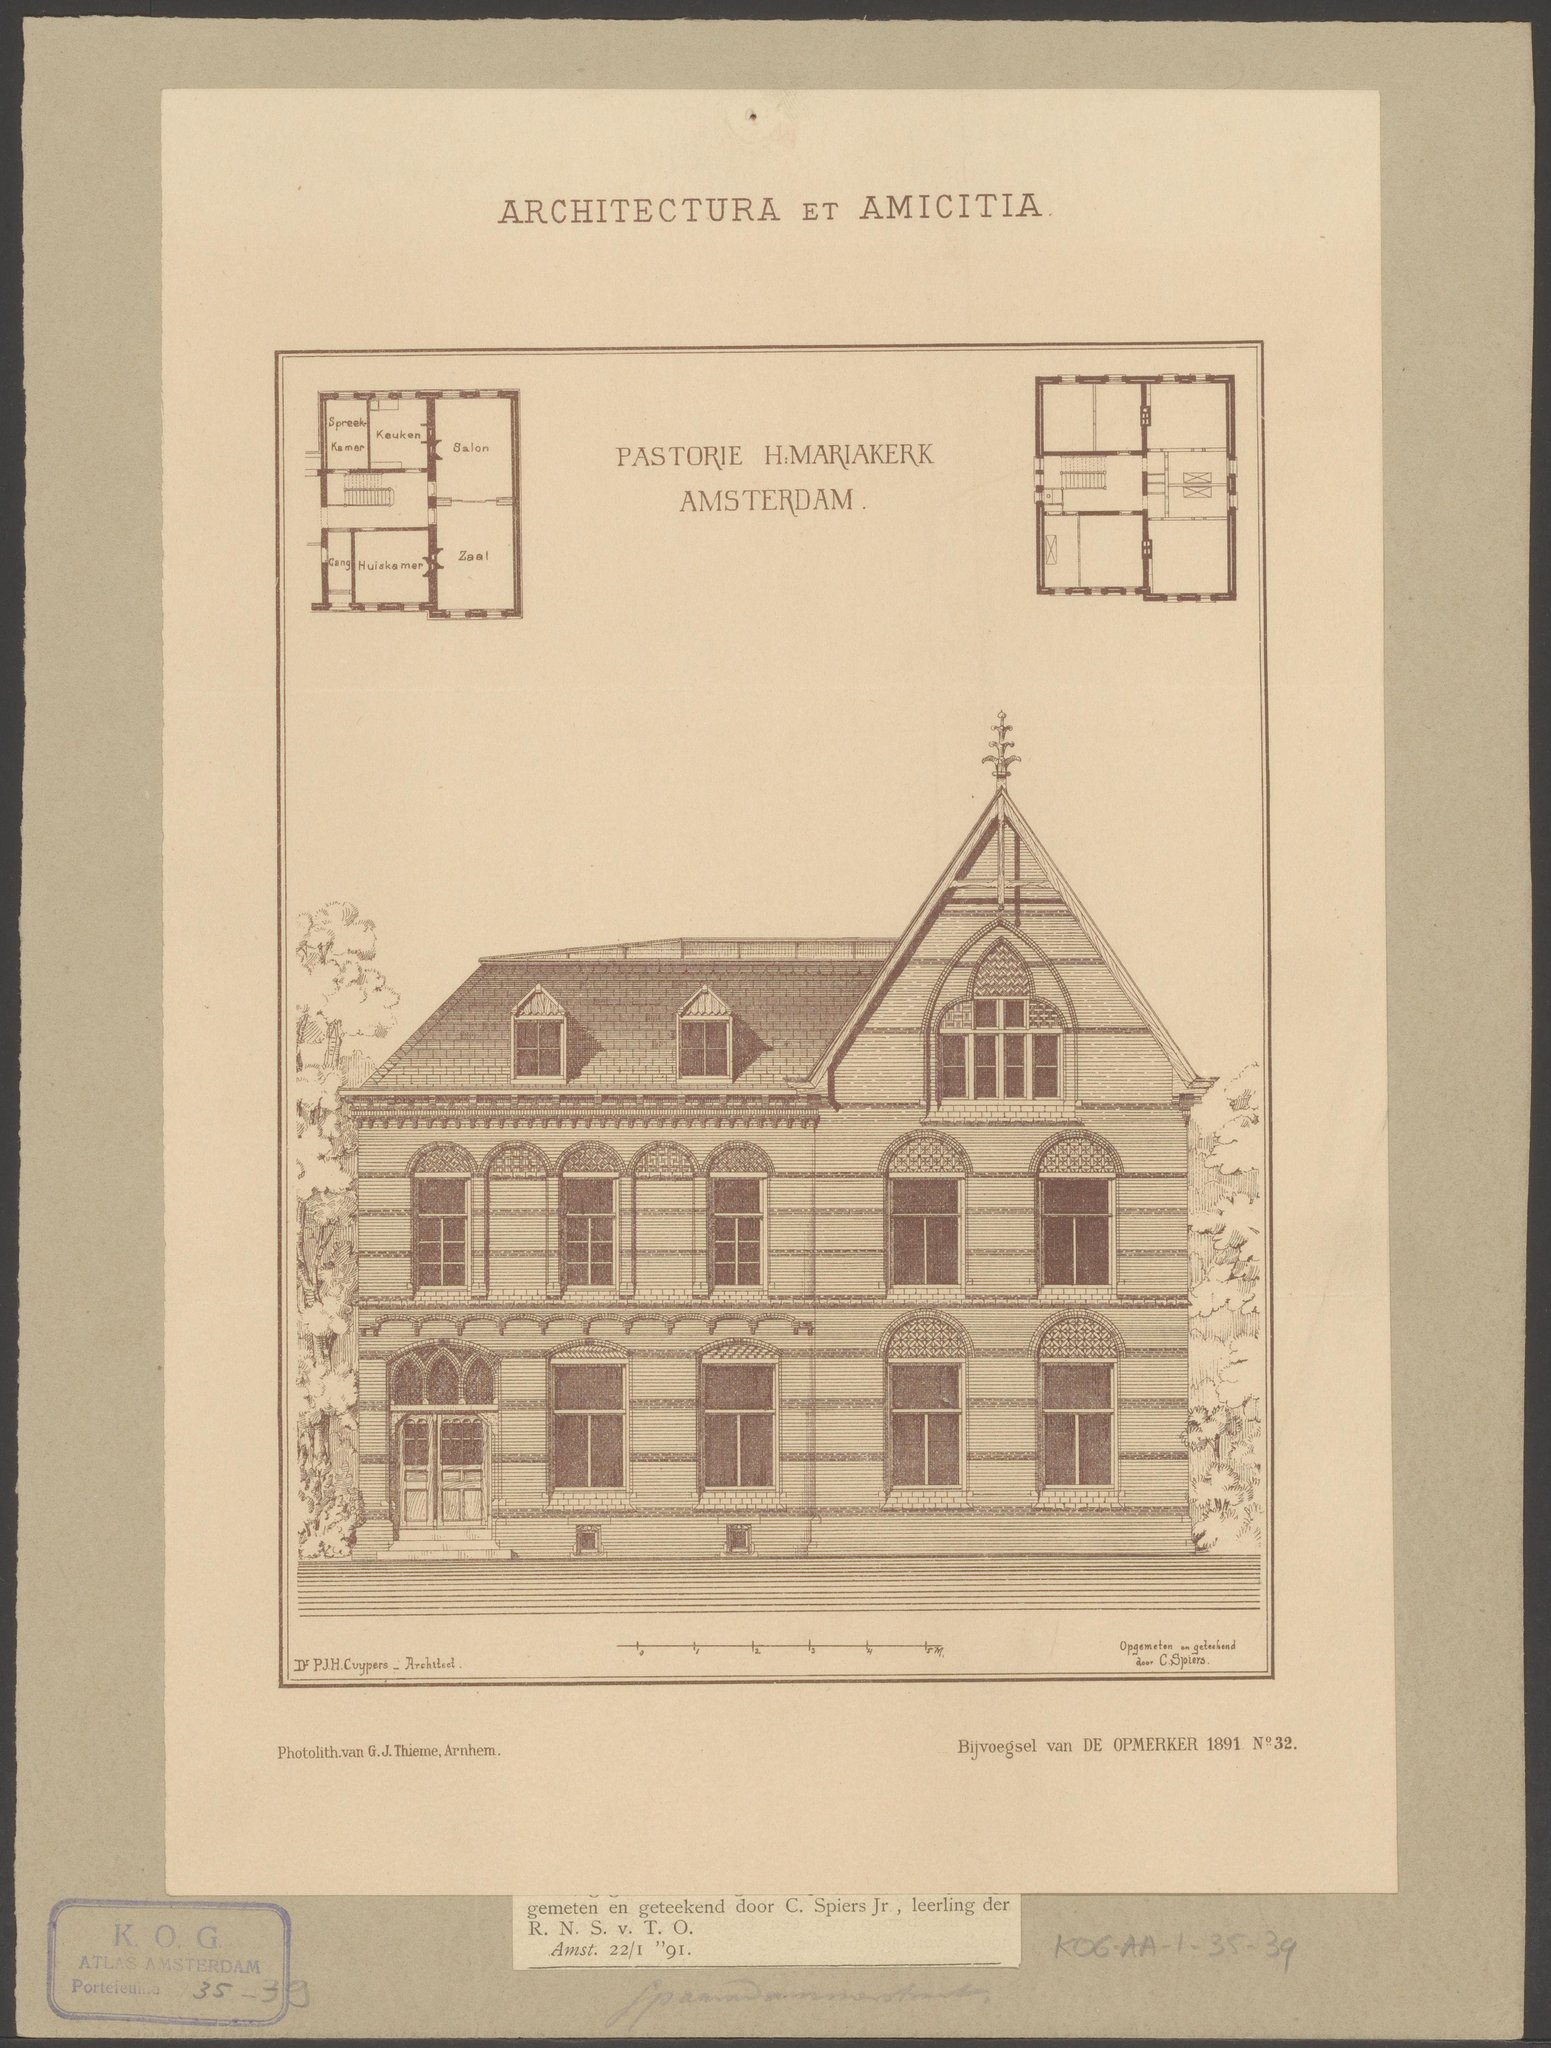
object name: print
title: Pastorie H:Mariakerk Amsterdam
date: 1891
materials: paper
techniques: letterpress printing, photolithography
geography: arnhem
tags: roman catholic church, parts of church exterior and annexes: façade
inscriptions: collector's mark: ‘35-39’ Lugt 1641b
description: Bijvoegsel en tekstknipsel van De Opmerker (1891). Gevelaanzicht, links- en rechtsboven een dwarsdoorsnede en onderaan een schaalstok. Onderwerpsrubriek binnen de Atlas Amsterdam: R.K. Gemeenten: Sint Nicolaaskerk t/m Willibrordus (Rustenburgerstraat).